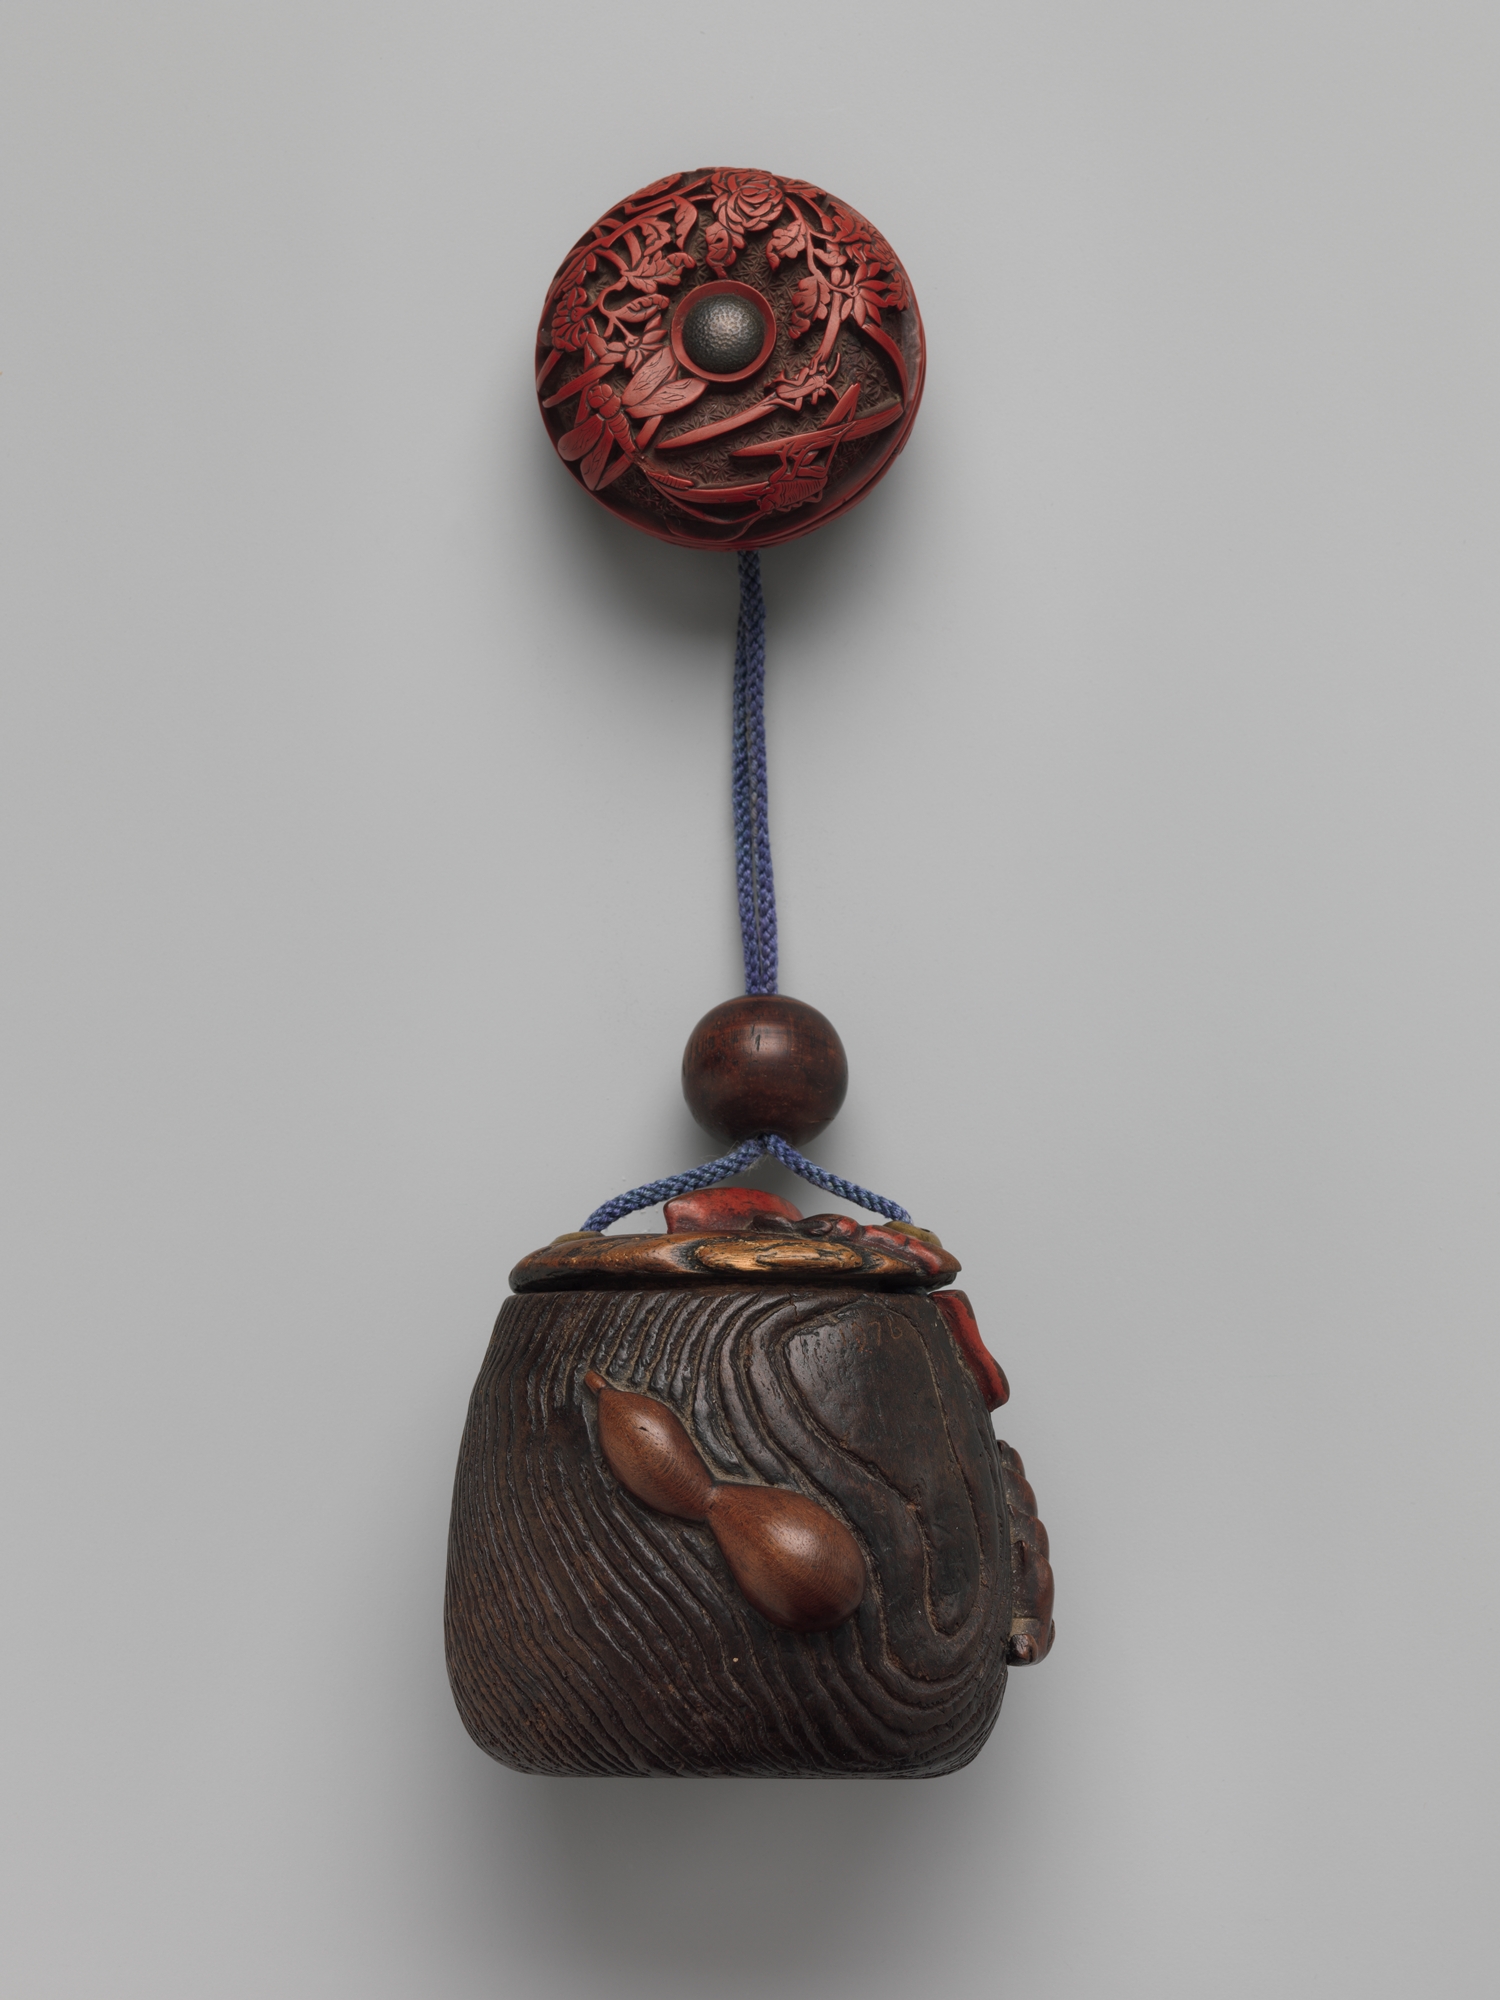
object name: tobacco pouch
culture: japanese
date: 1850-1880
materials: lacquer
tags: insects,gourds